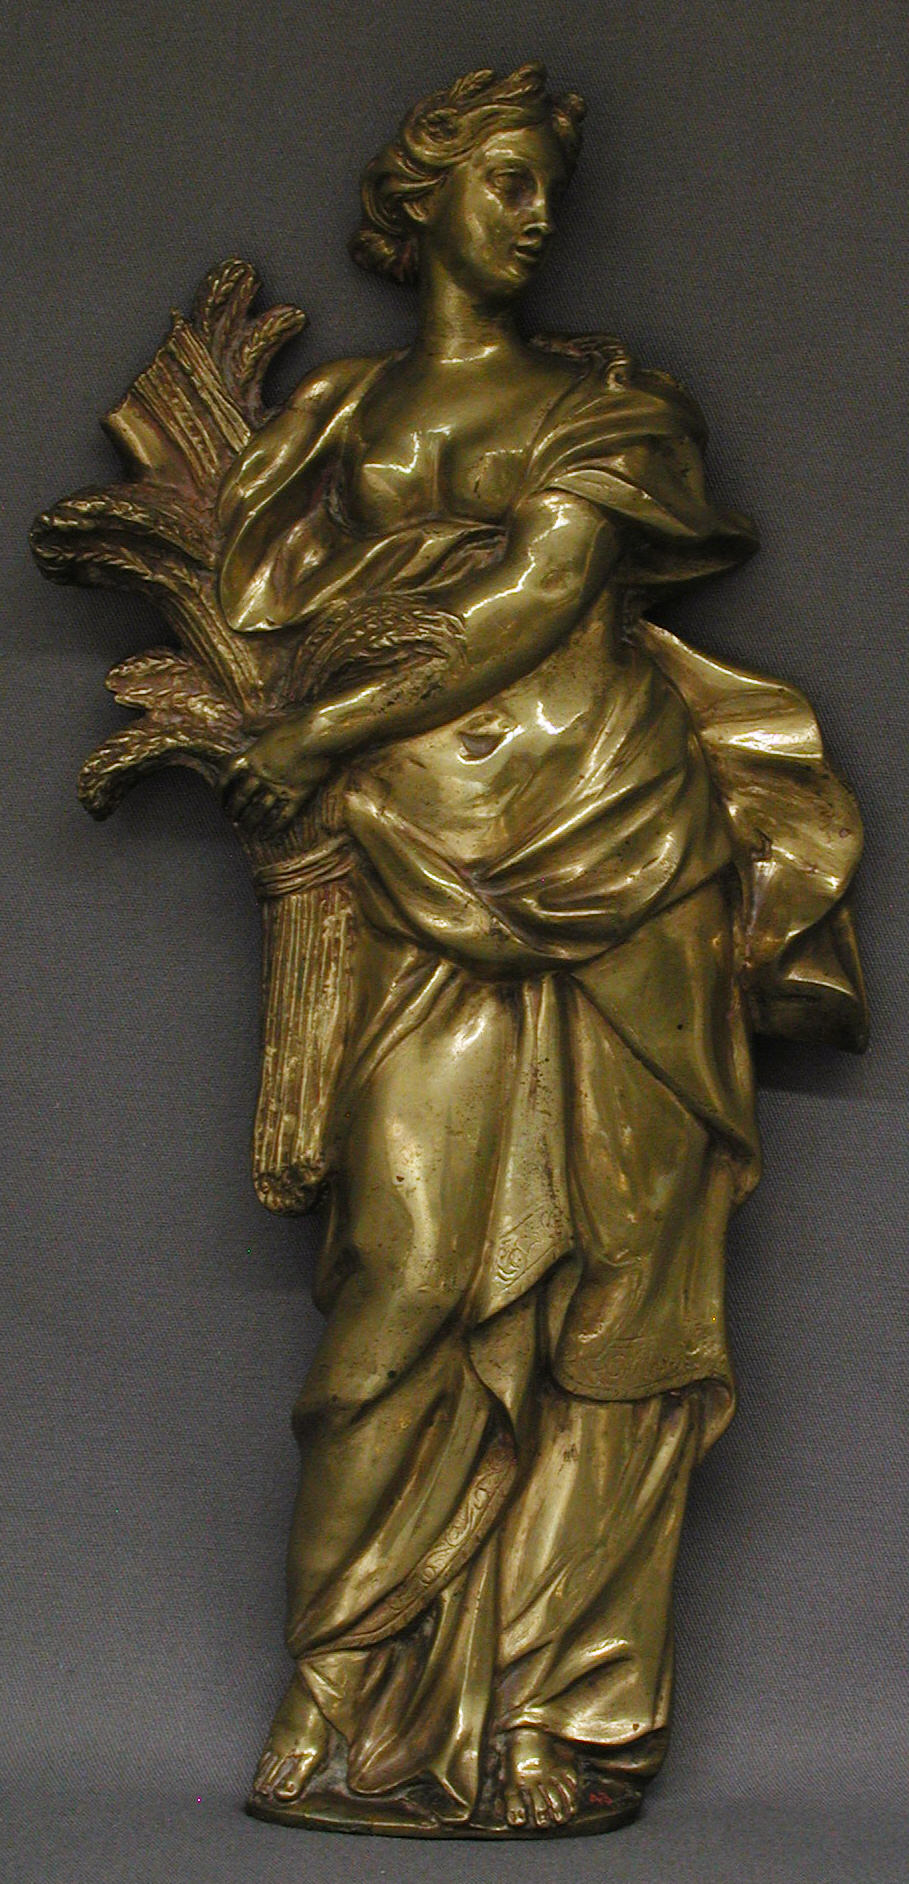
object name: panel ornament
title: Panel ornament (part of a set)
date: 1667-1733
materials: gilt bronze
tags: women